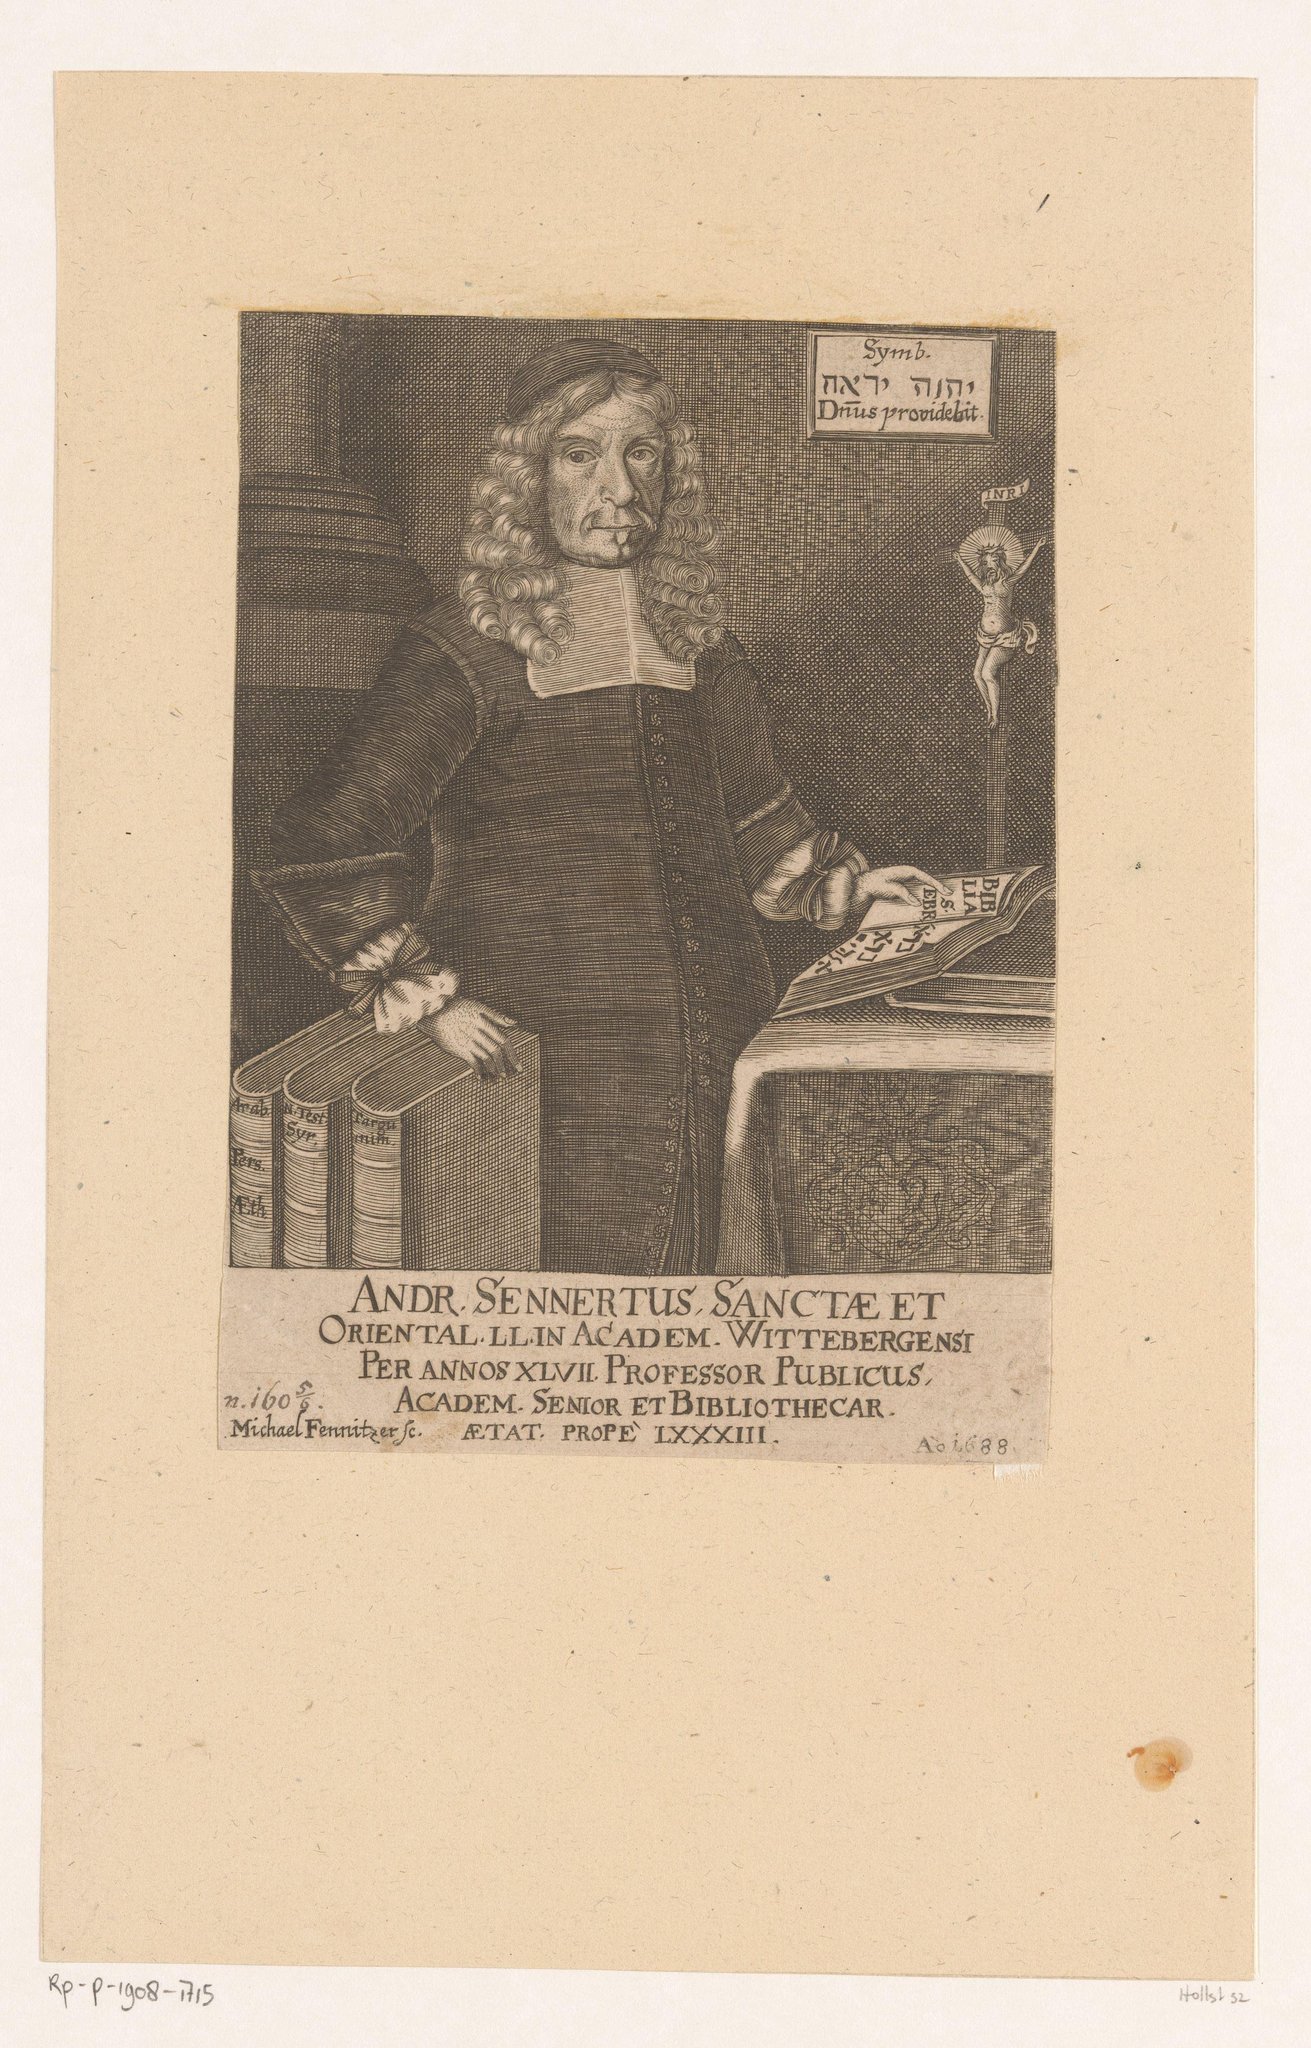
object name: print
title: Portret van Andreas Sennert op 83-jarige leeftijd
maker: michael fennitzer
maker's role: print maker, printer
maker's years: 1641-1702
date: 1688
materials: paper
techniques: engraving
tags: historical persons, book, crucifix ~ personal devotion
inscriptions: collector's mark: Lugt 2228